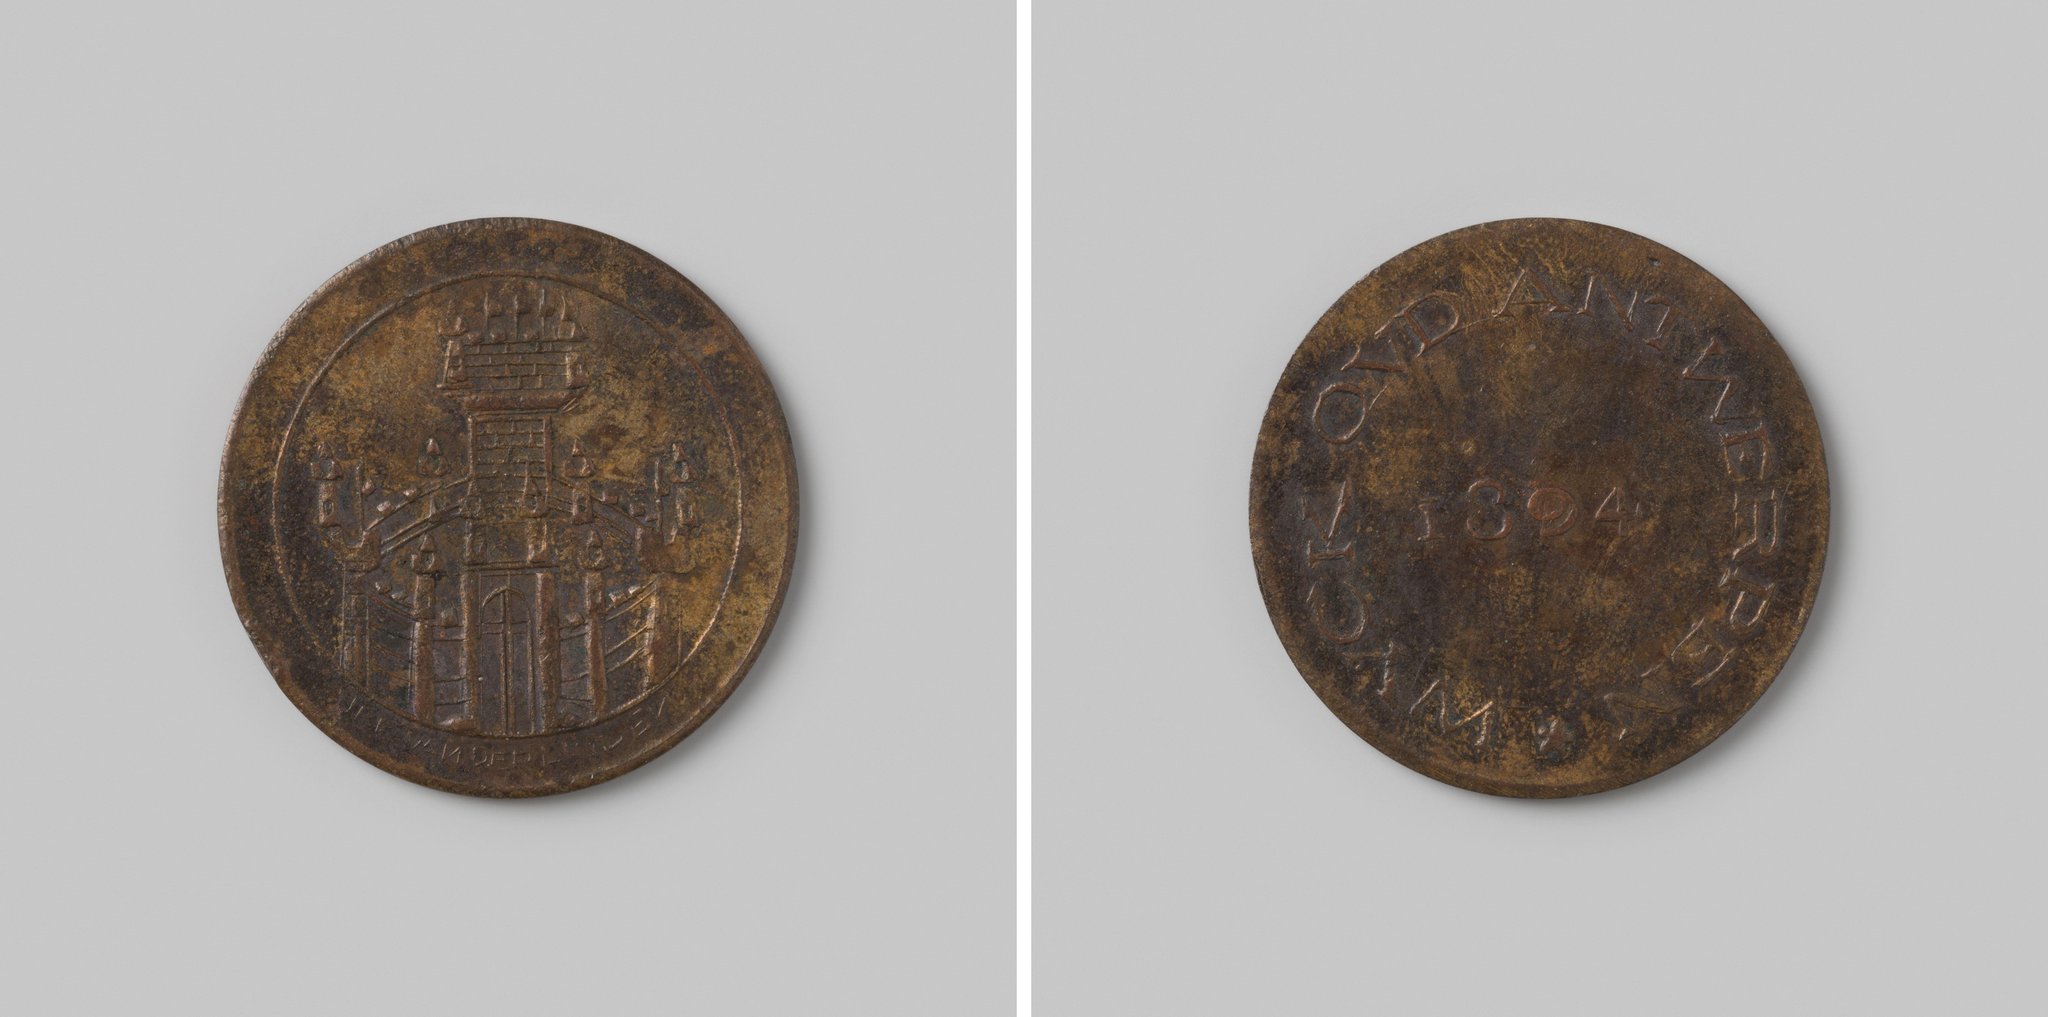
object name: history medal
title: Wereldtentoonstelling te Antwerpen (Wyck ovd Antwerpen) 1894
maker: jef van der linden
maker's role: designer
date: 1894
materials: brass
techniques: striking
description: Messing penning, op de voorzijde een ronde burcht met hoofdtoren binnen een cirkel, op de keerzijde het jaartal 1894 met omschrift.